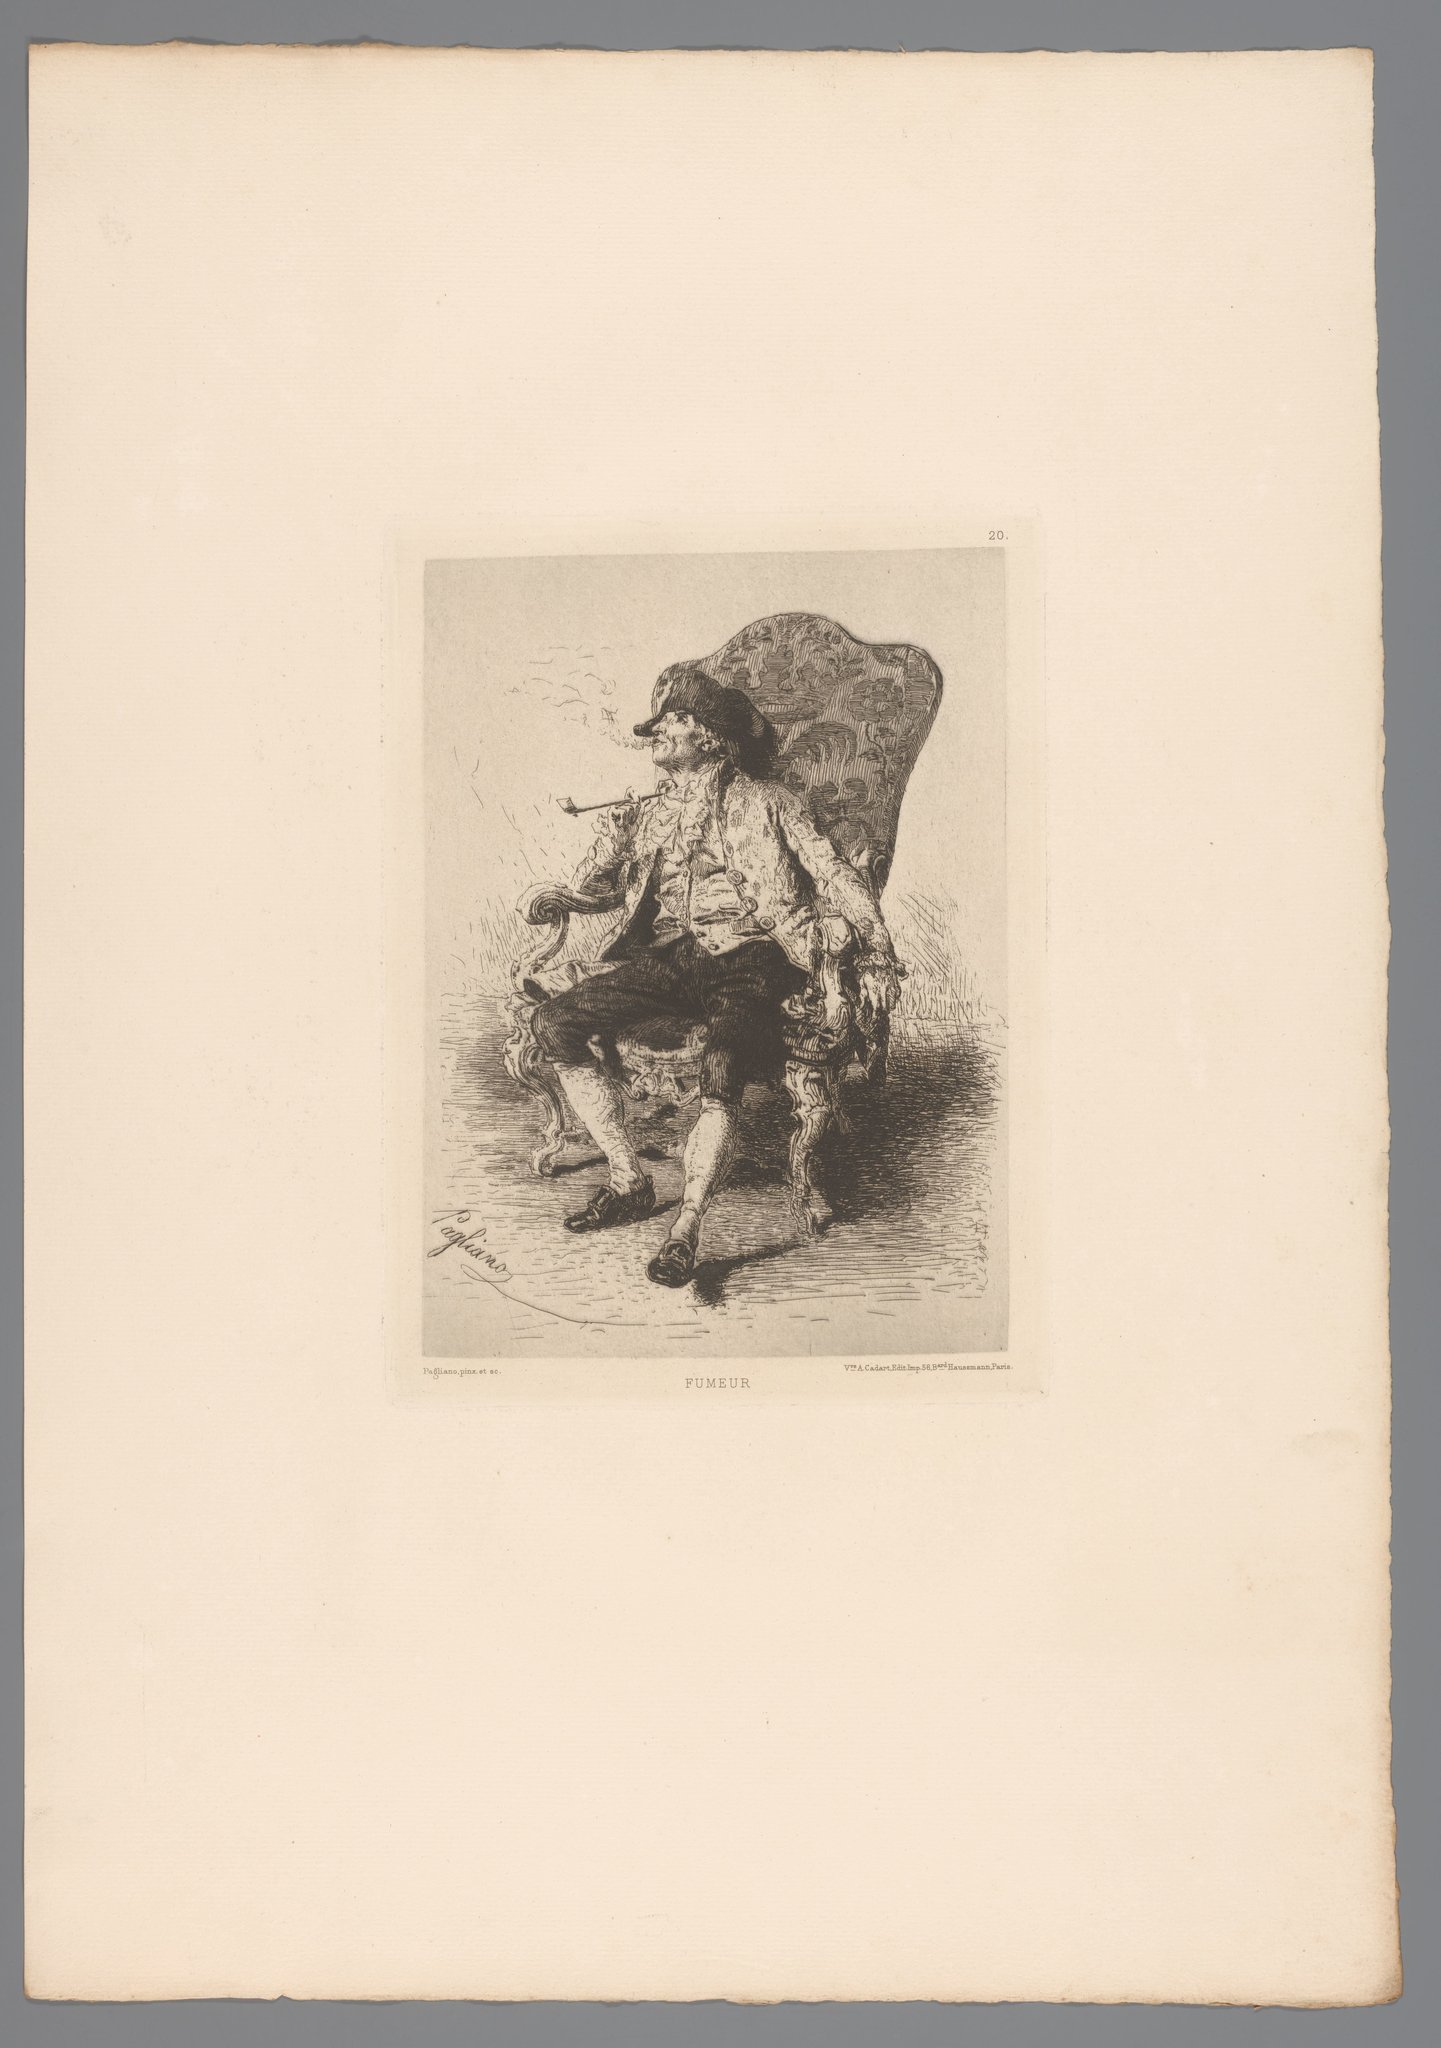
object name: print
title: Fumeur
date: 1879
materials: paper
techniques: drypoint, etching, intaglio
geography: paris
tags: sitting figure, pipe ~ tobacco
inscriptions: collector's mark: Lugt 2760, collector's mark: ‘AFE v S’, collector's mark: Lugt 2228